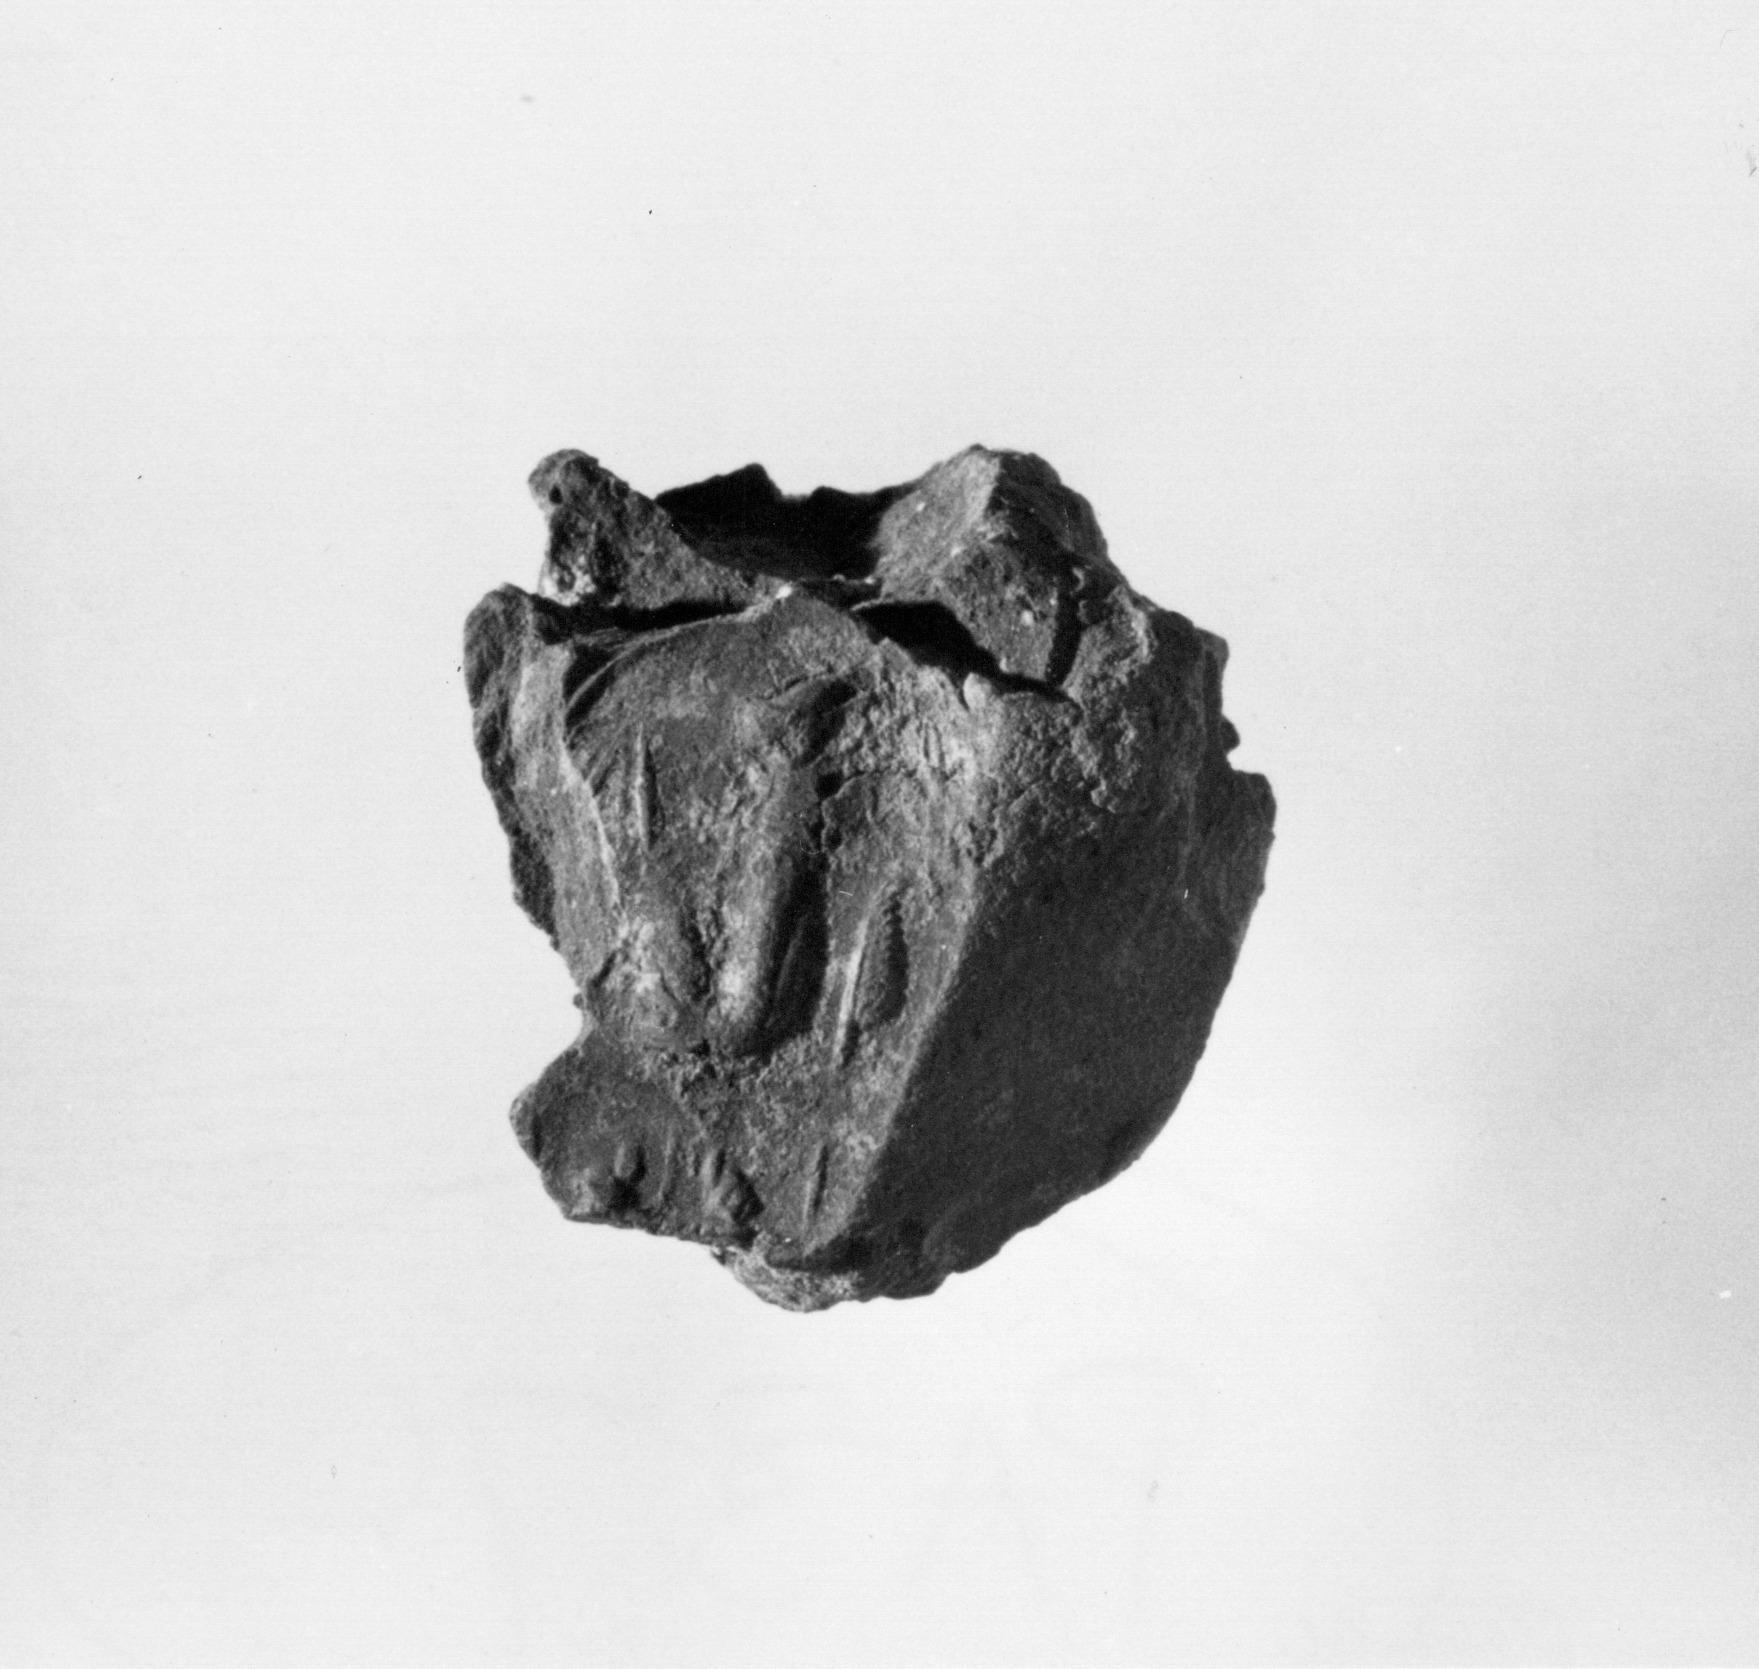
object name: sealing, nebmaatre, amenhotep iii, heb sed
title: Document Sealing With the Throne Name of Amenhotep III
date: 1390-1352 BCE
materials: mud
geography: egypt